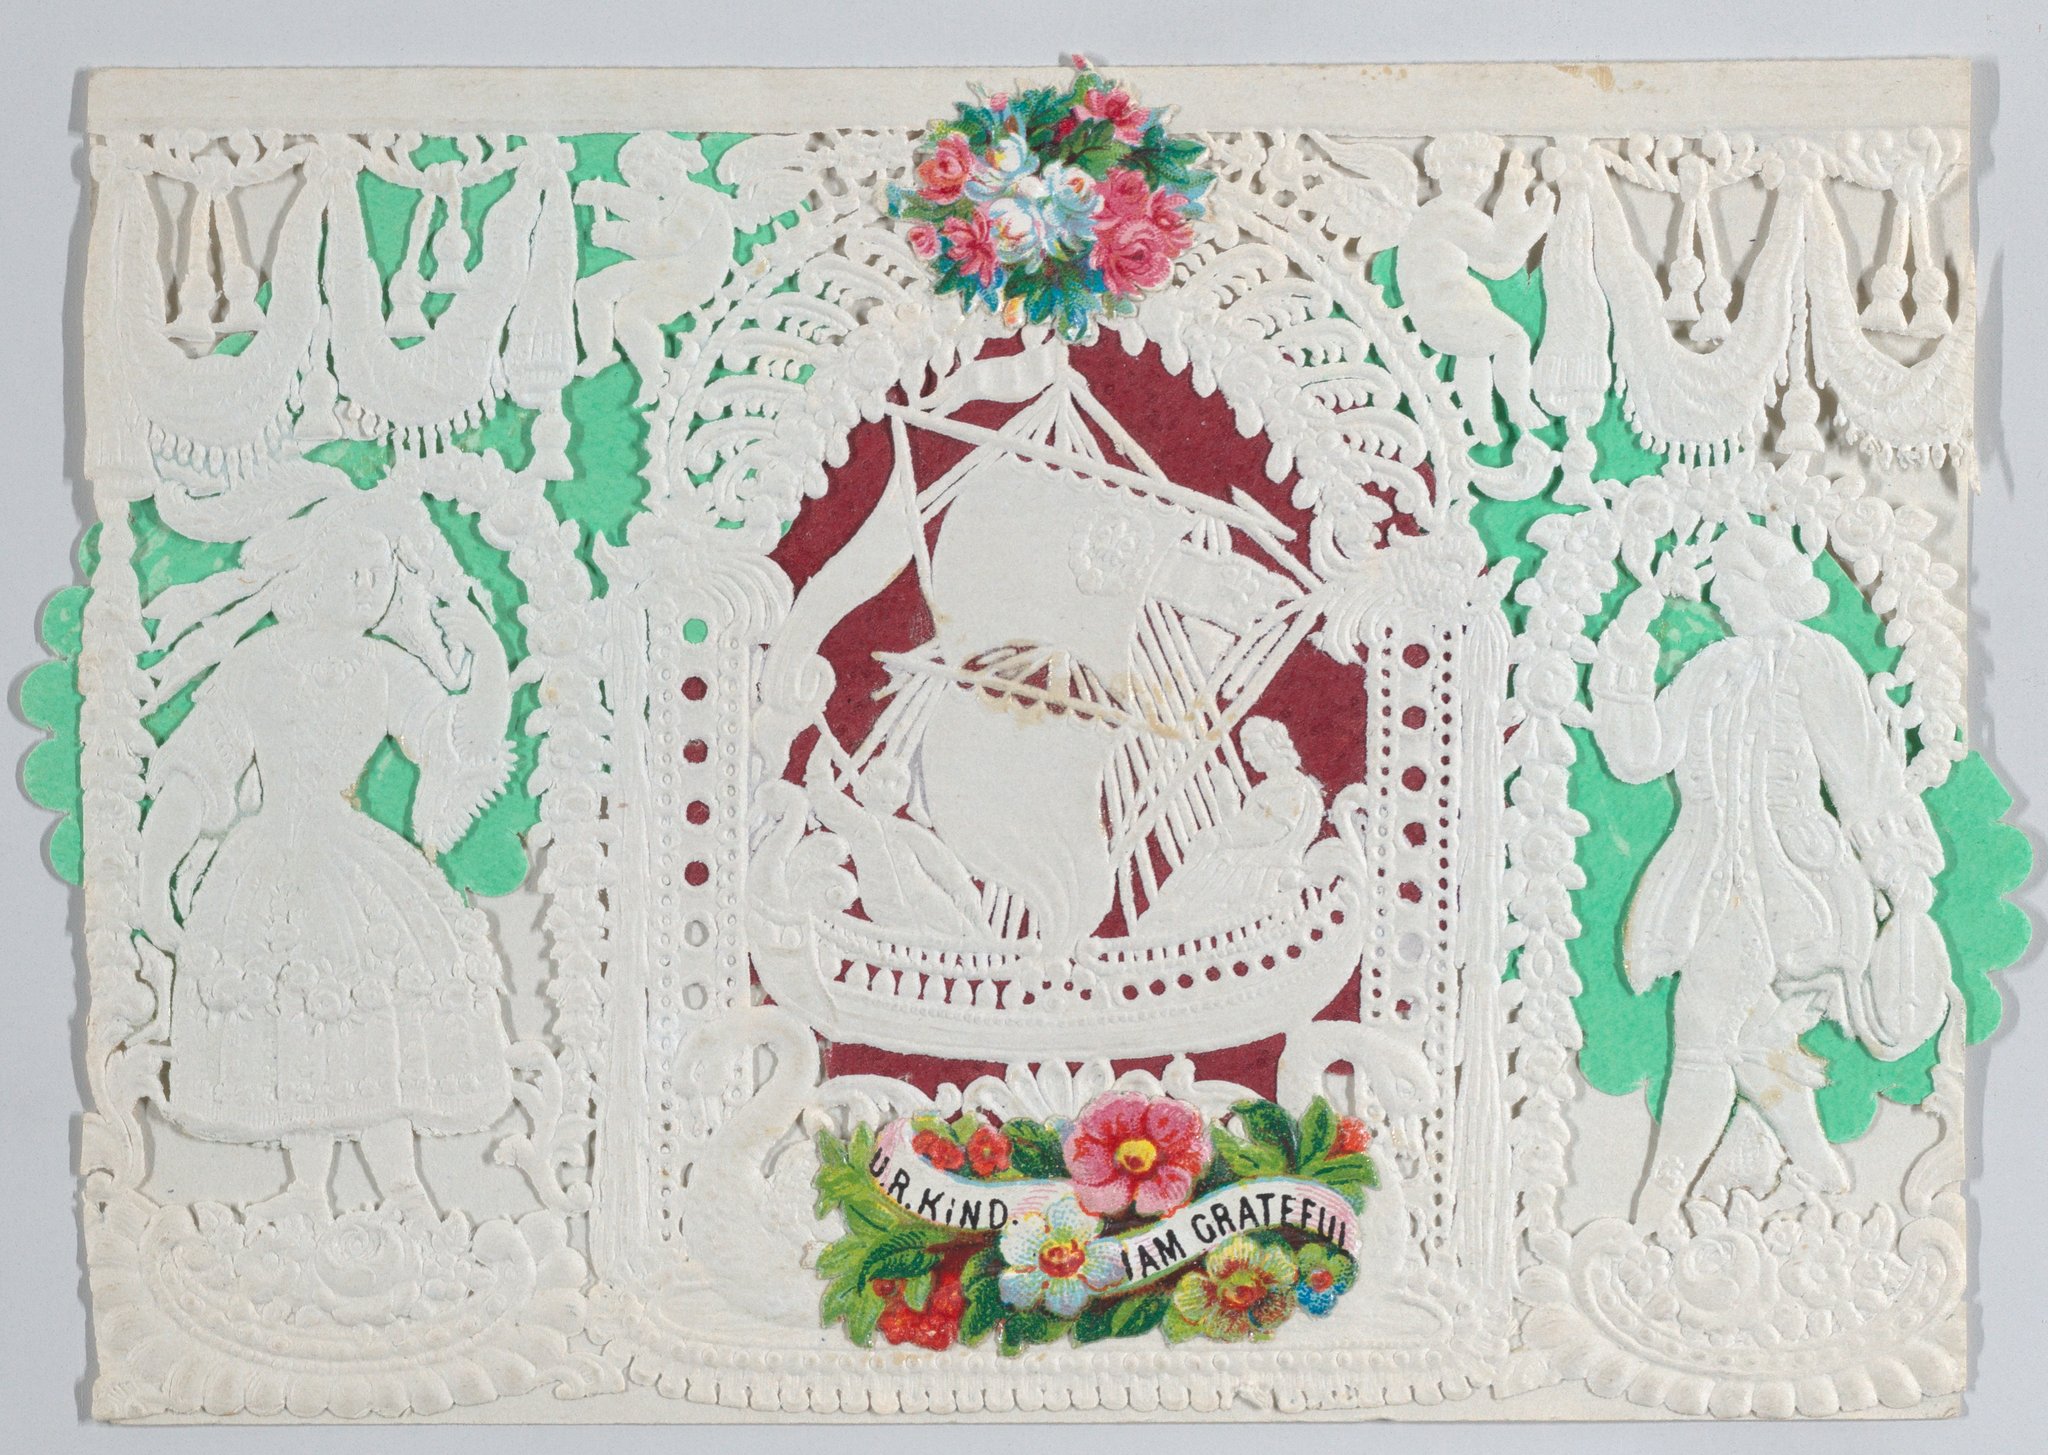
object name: valentine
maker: Anonymous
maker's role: artist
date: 1850-1870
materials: lace, paper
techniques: chromolithography, embossing, open work